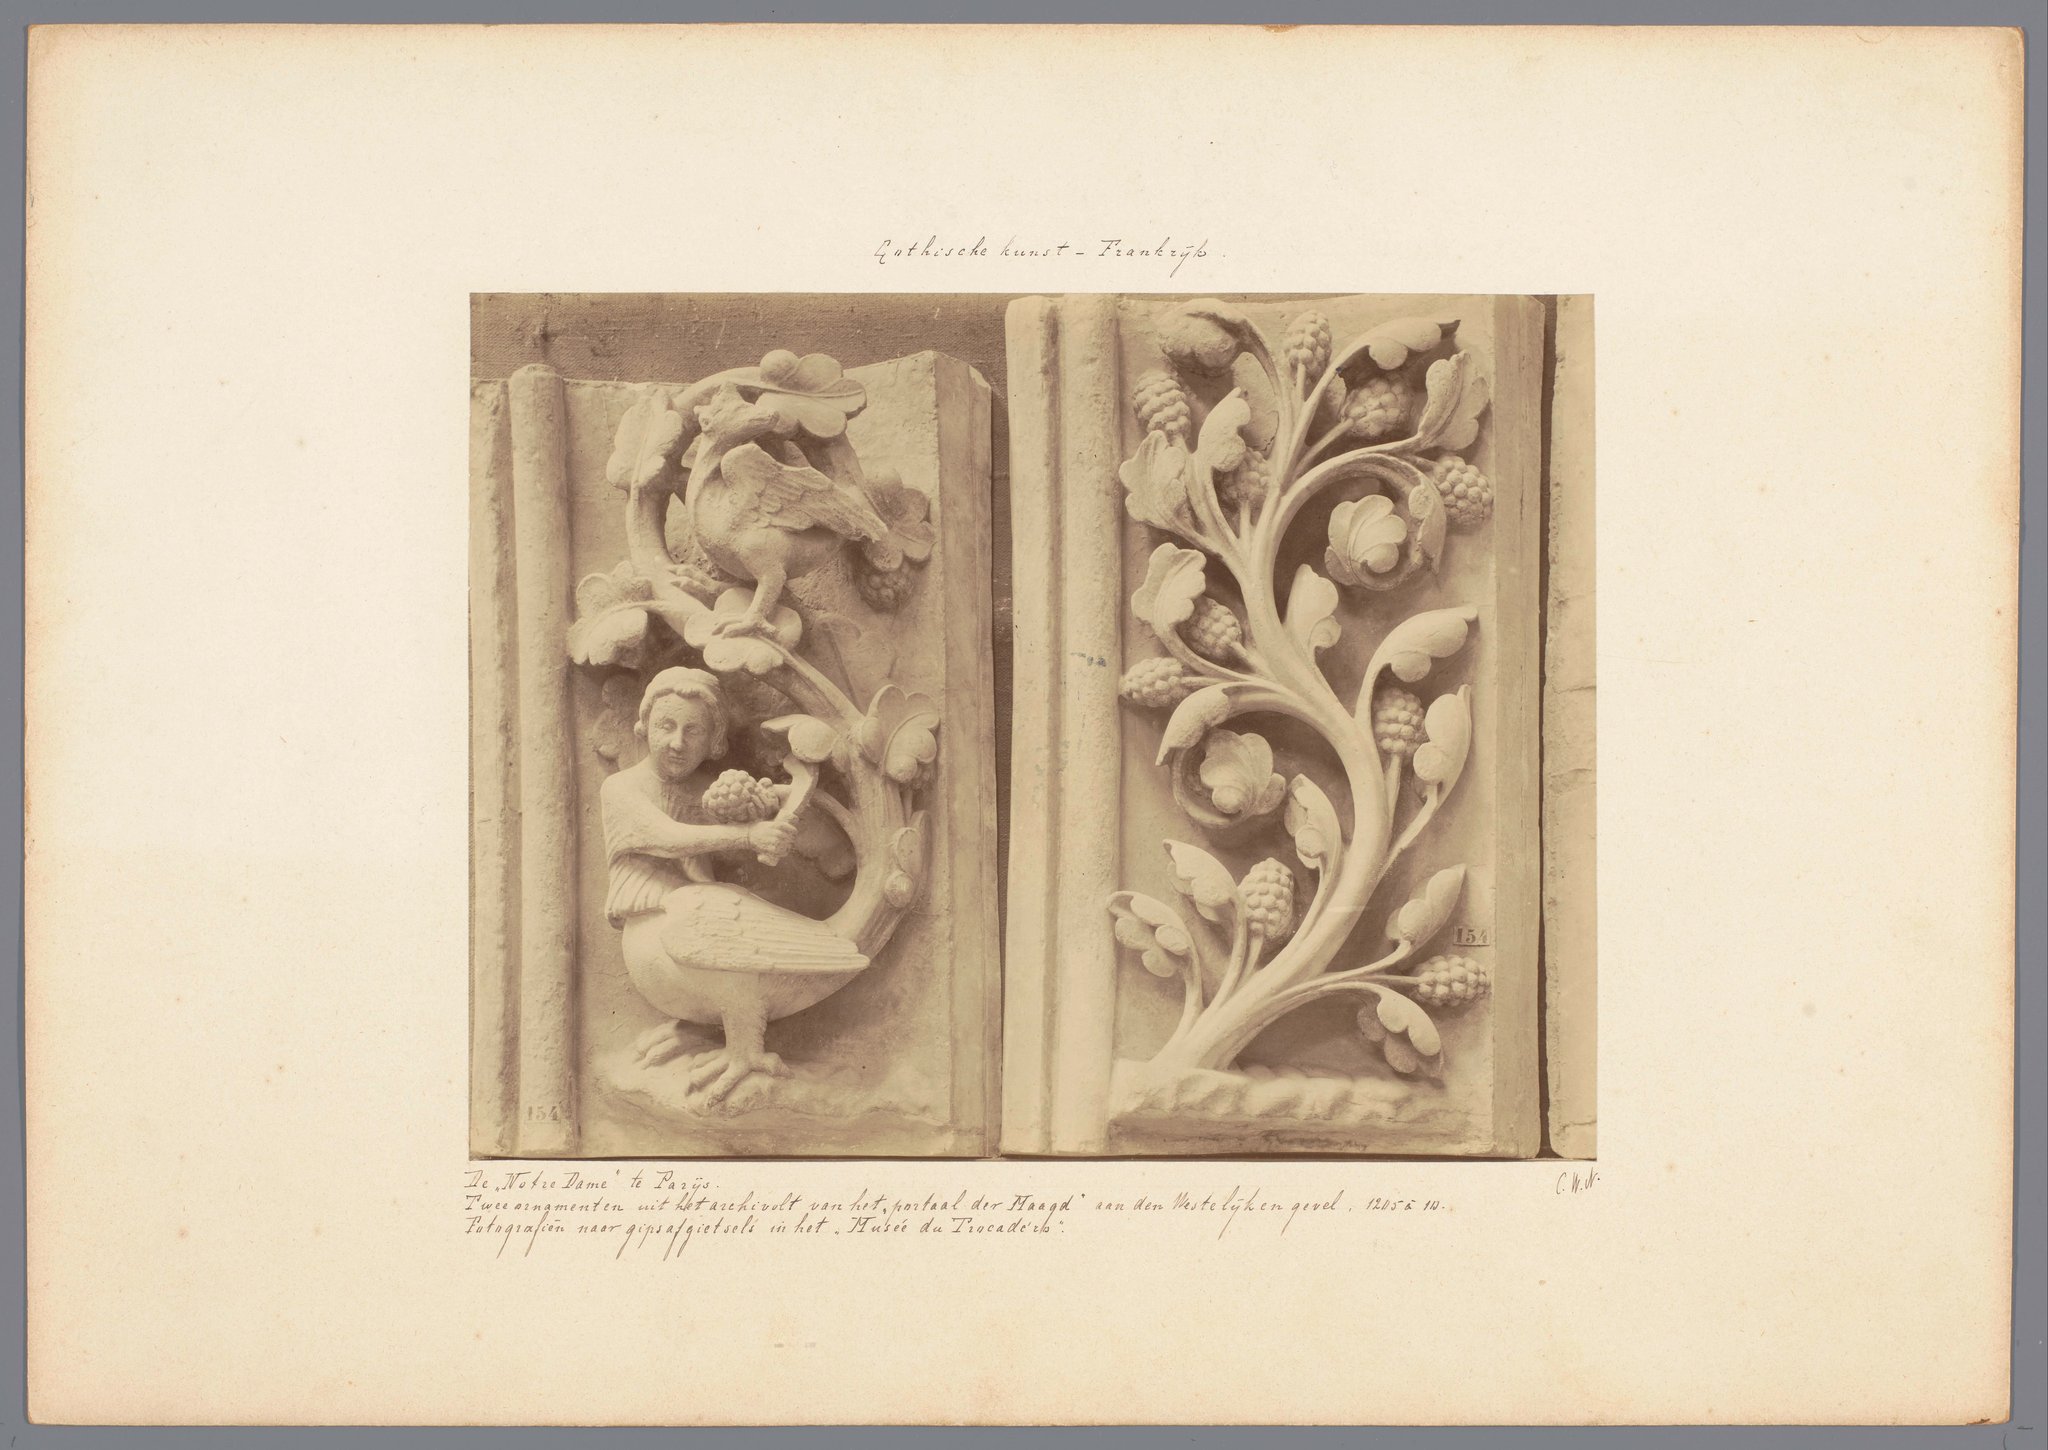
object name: photograph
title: Twee gipsafgietsels van reliëfs, afkomstig van de gevel van de Notre-Dame te Parijs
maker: Anonymous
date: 1875-1900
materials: cardboard, photographic support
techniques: albumen print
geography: palais du trocadéro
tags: ornament ~ hybrid beings; human and animal forms mixed, tendrils ~ ornament, sculpture (+ relief ~ sculpture)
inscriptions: inscription: ‘Gothische Kunst - Frankrijk. ,,Notre-Dame'' te Parijs. Twee ornamenten (...) Fotografiën naar gipsafgietsels in het ,,Musée du Trocadéro''.’, collector's mark: ‘INSTITUUT VOOR KUNST- NIJVERHEIDSONDERWIJS GABRIËL METSUSTRAAT No. 16. AMSTERDAM’, inscription: ‘CWN.’, collector's mark: ‘KUNSTNIJVERHEIDSCHOOL QUELLINUS AMSTERDAM FRANS HALSSTRAAT 14.’